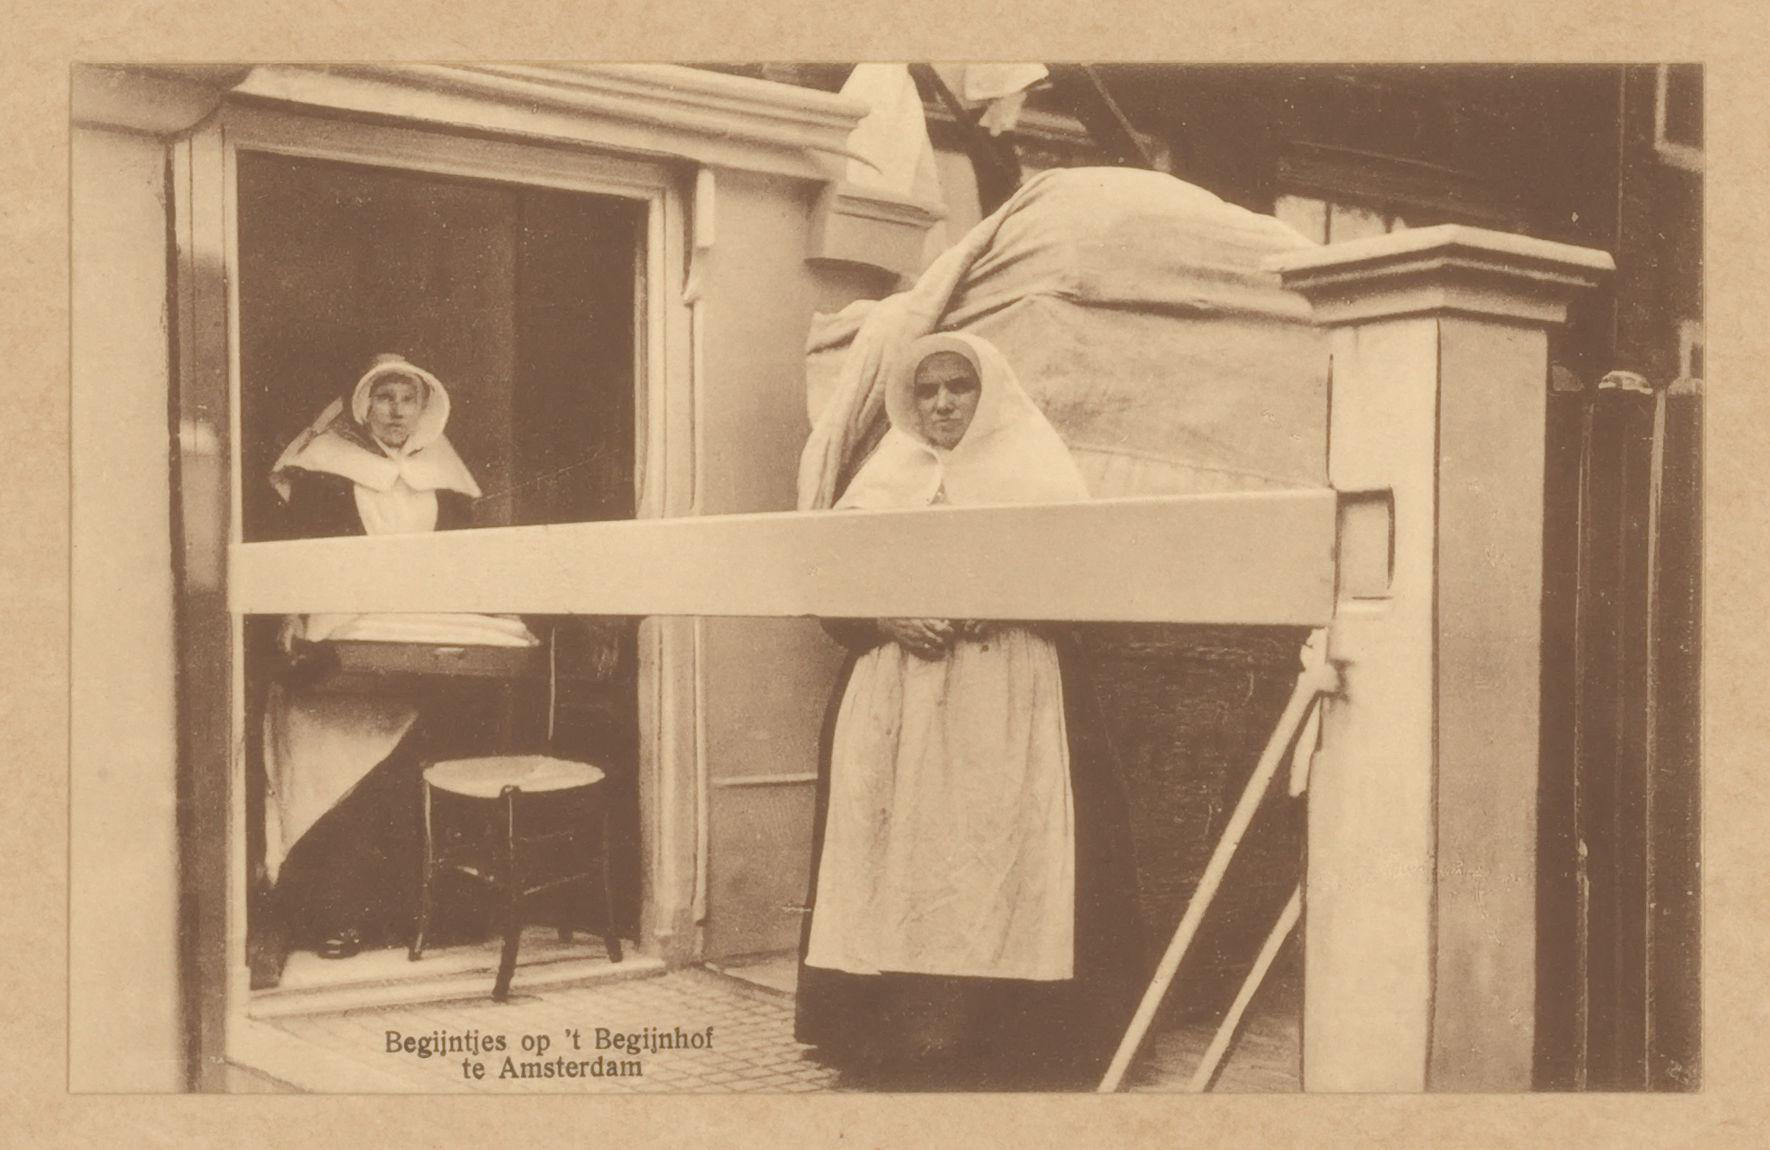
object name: photomechanical print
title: Twee begijnen uit het Begijnhof te Amsterdam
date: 1905-1919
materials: paper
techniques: photograph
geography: netherlands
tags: beguines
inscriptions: collector's mark: Lugt 1641b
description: Onderwerpsrubriek binnen de Atlas Amsterdam: Kerkwezen: R.K. Gemeenten: Begijnhof t/m Petrus en Paulus.